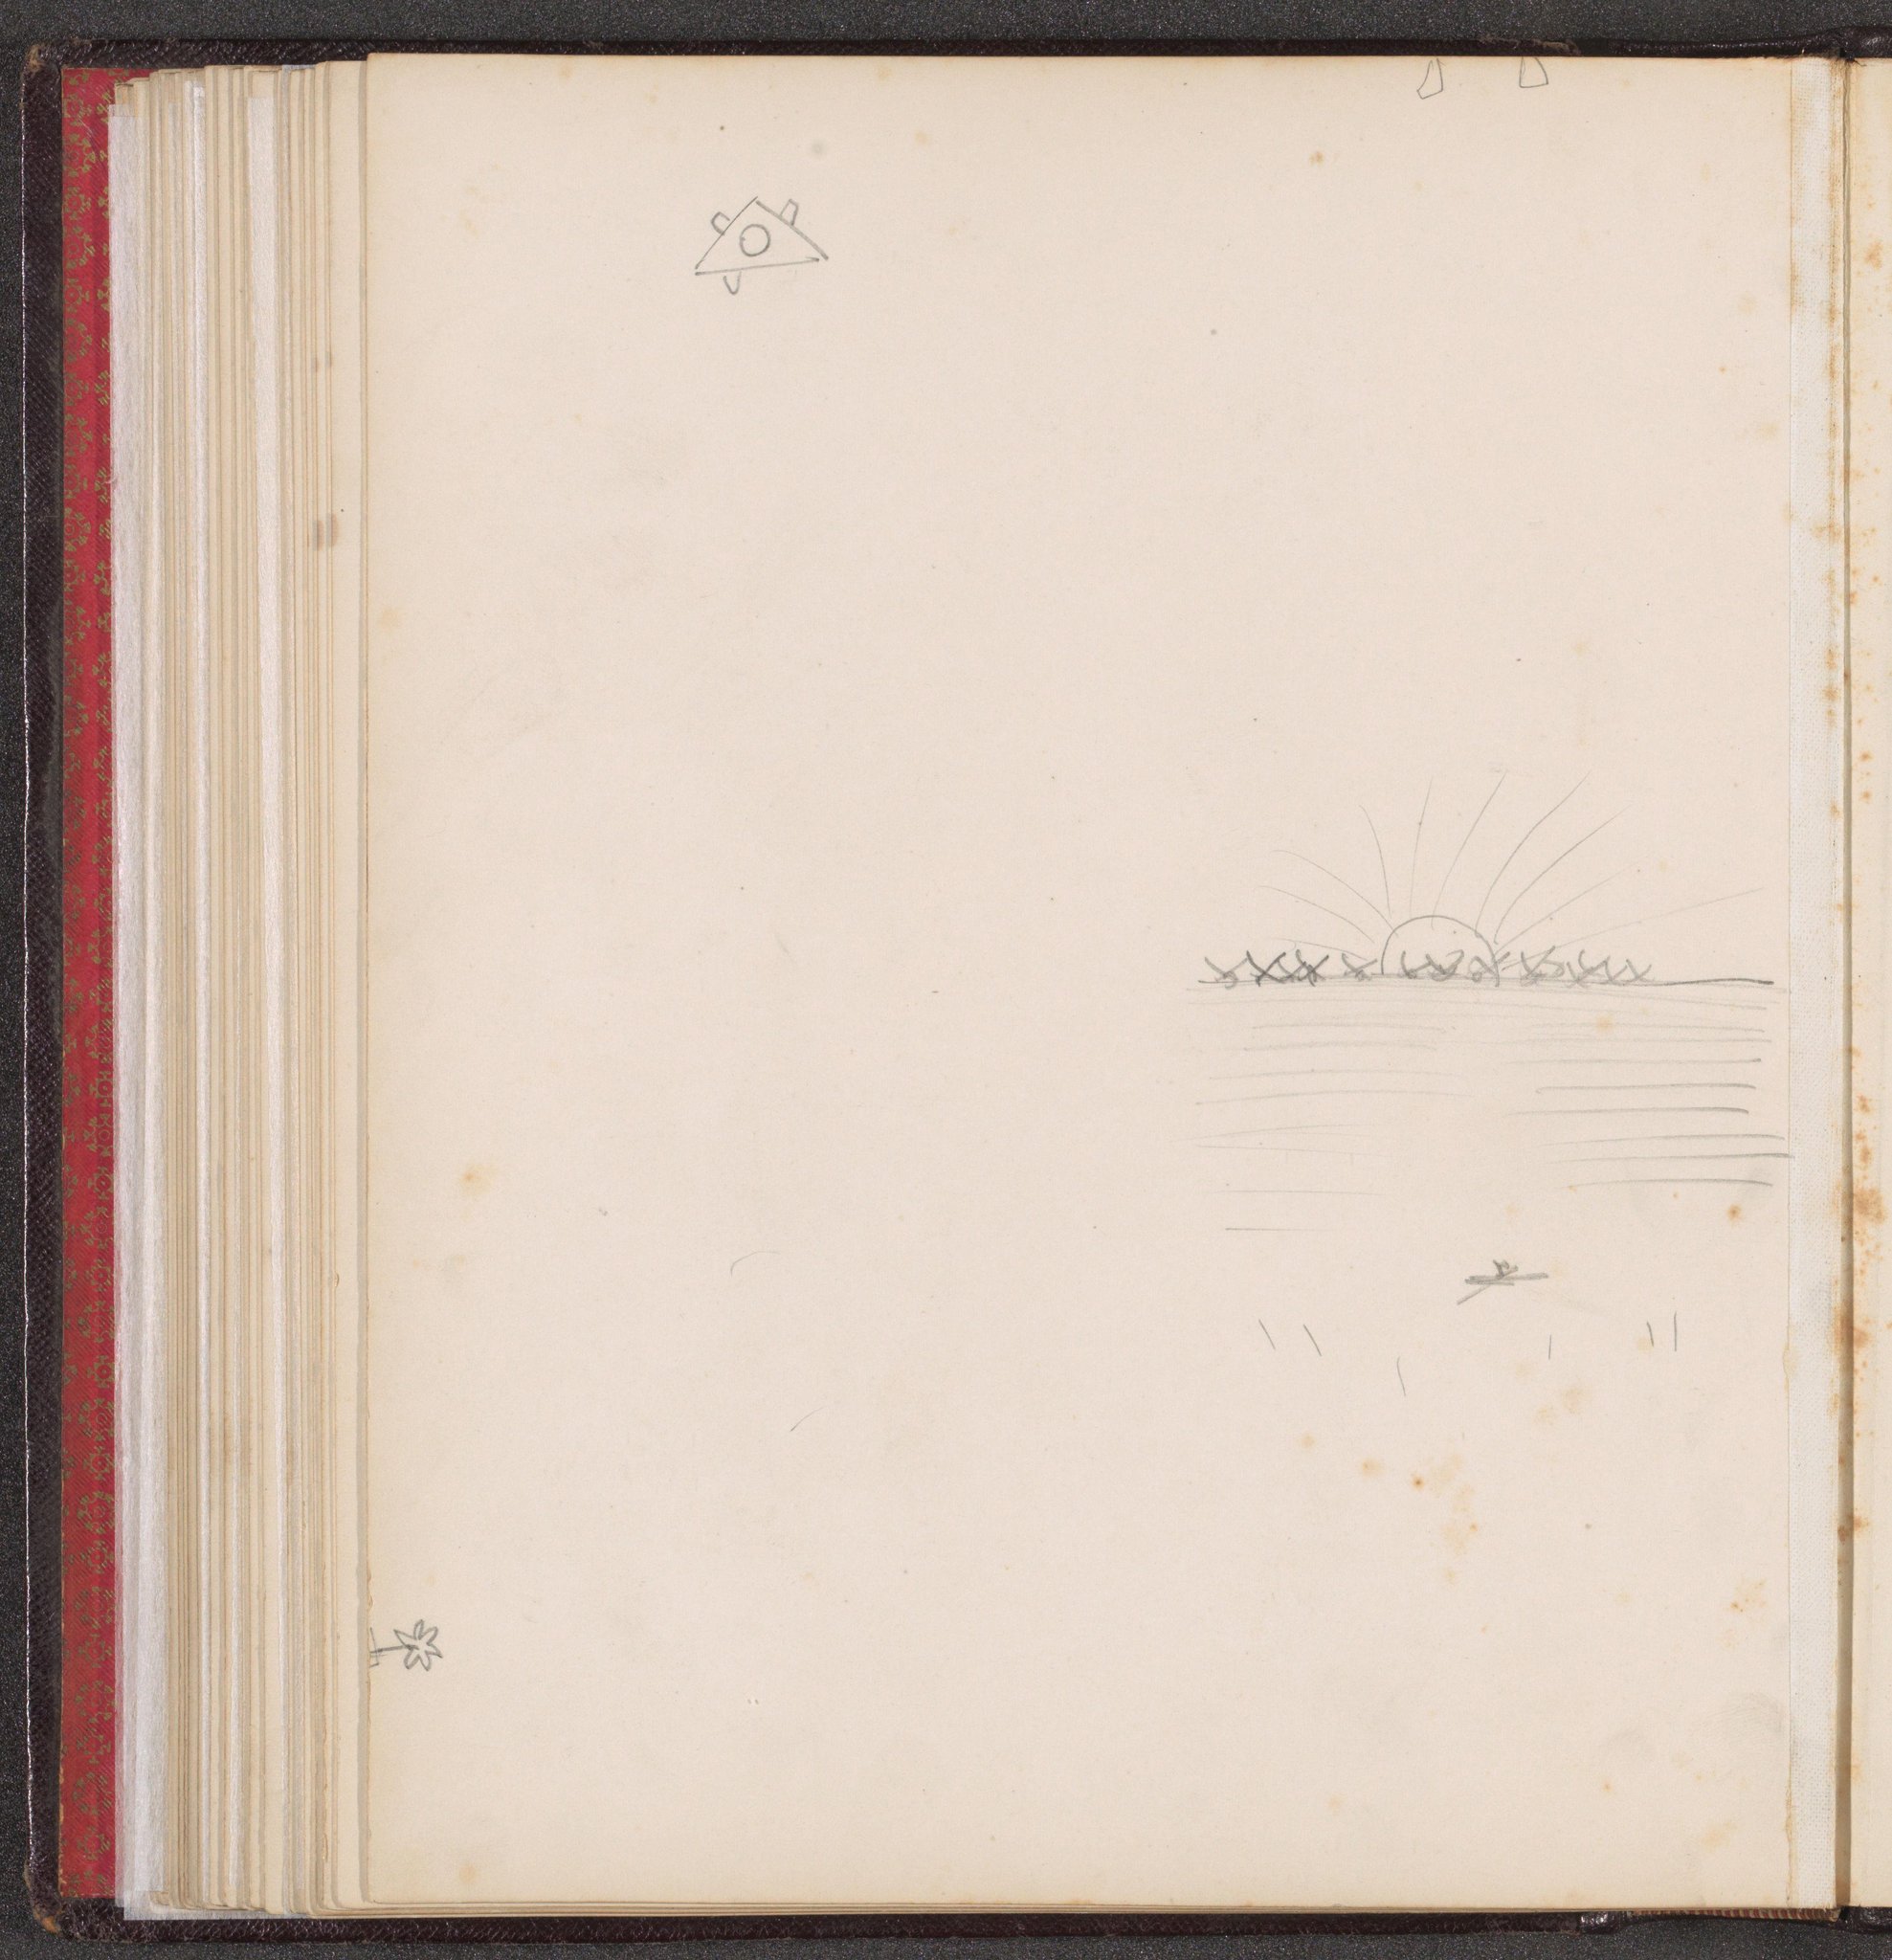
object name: drawing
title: Zonsopkomst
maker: Anonymous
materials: paper, pencil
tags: sunrise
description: Tevens twee studies. Blad maakt deel uit van een album met ingeplakte tekeningen.